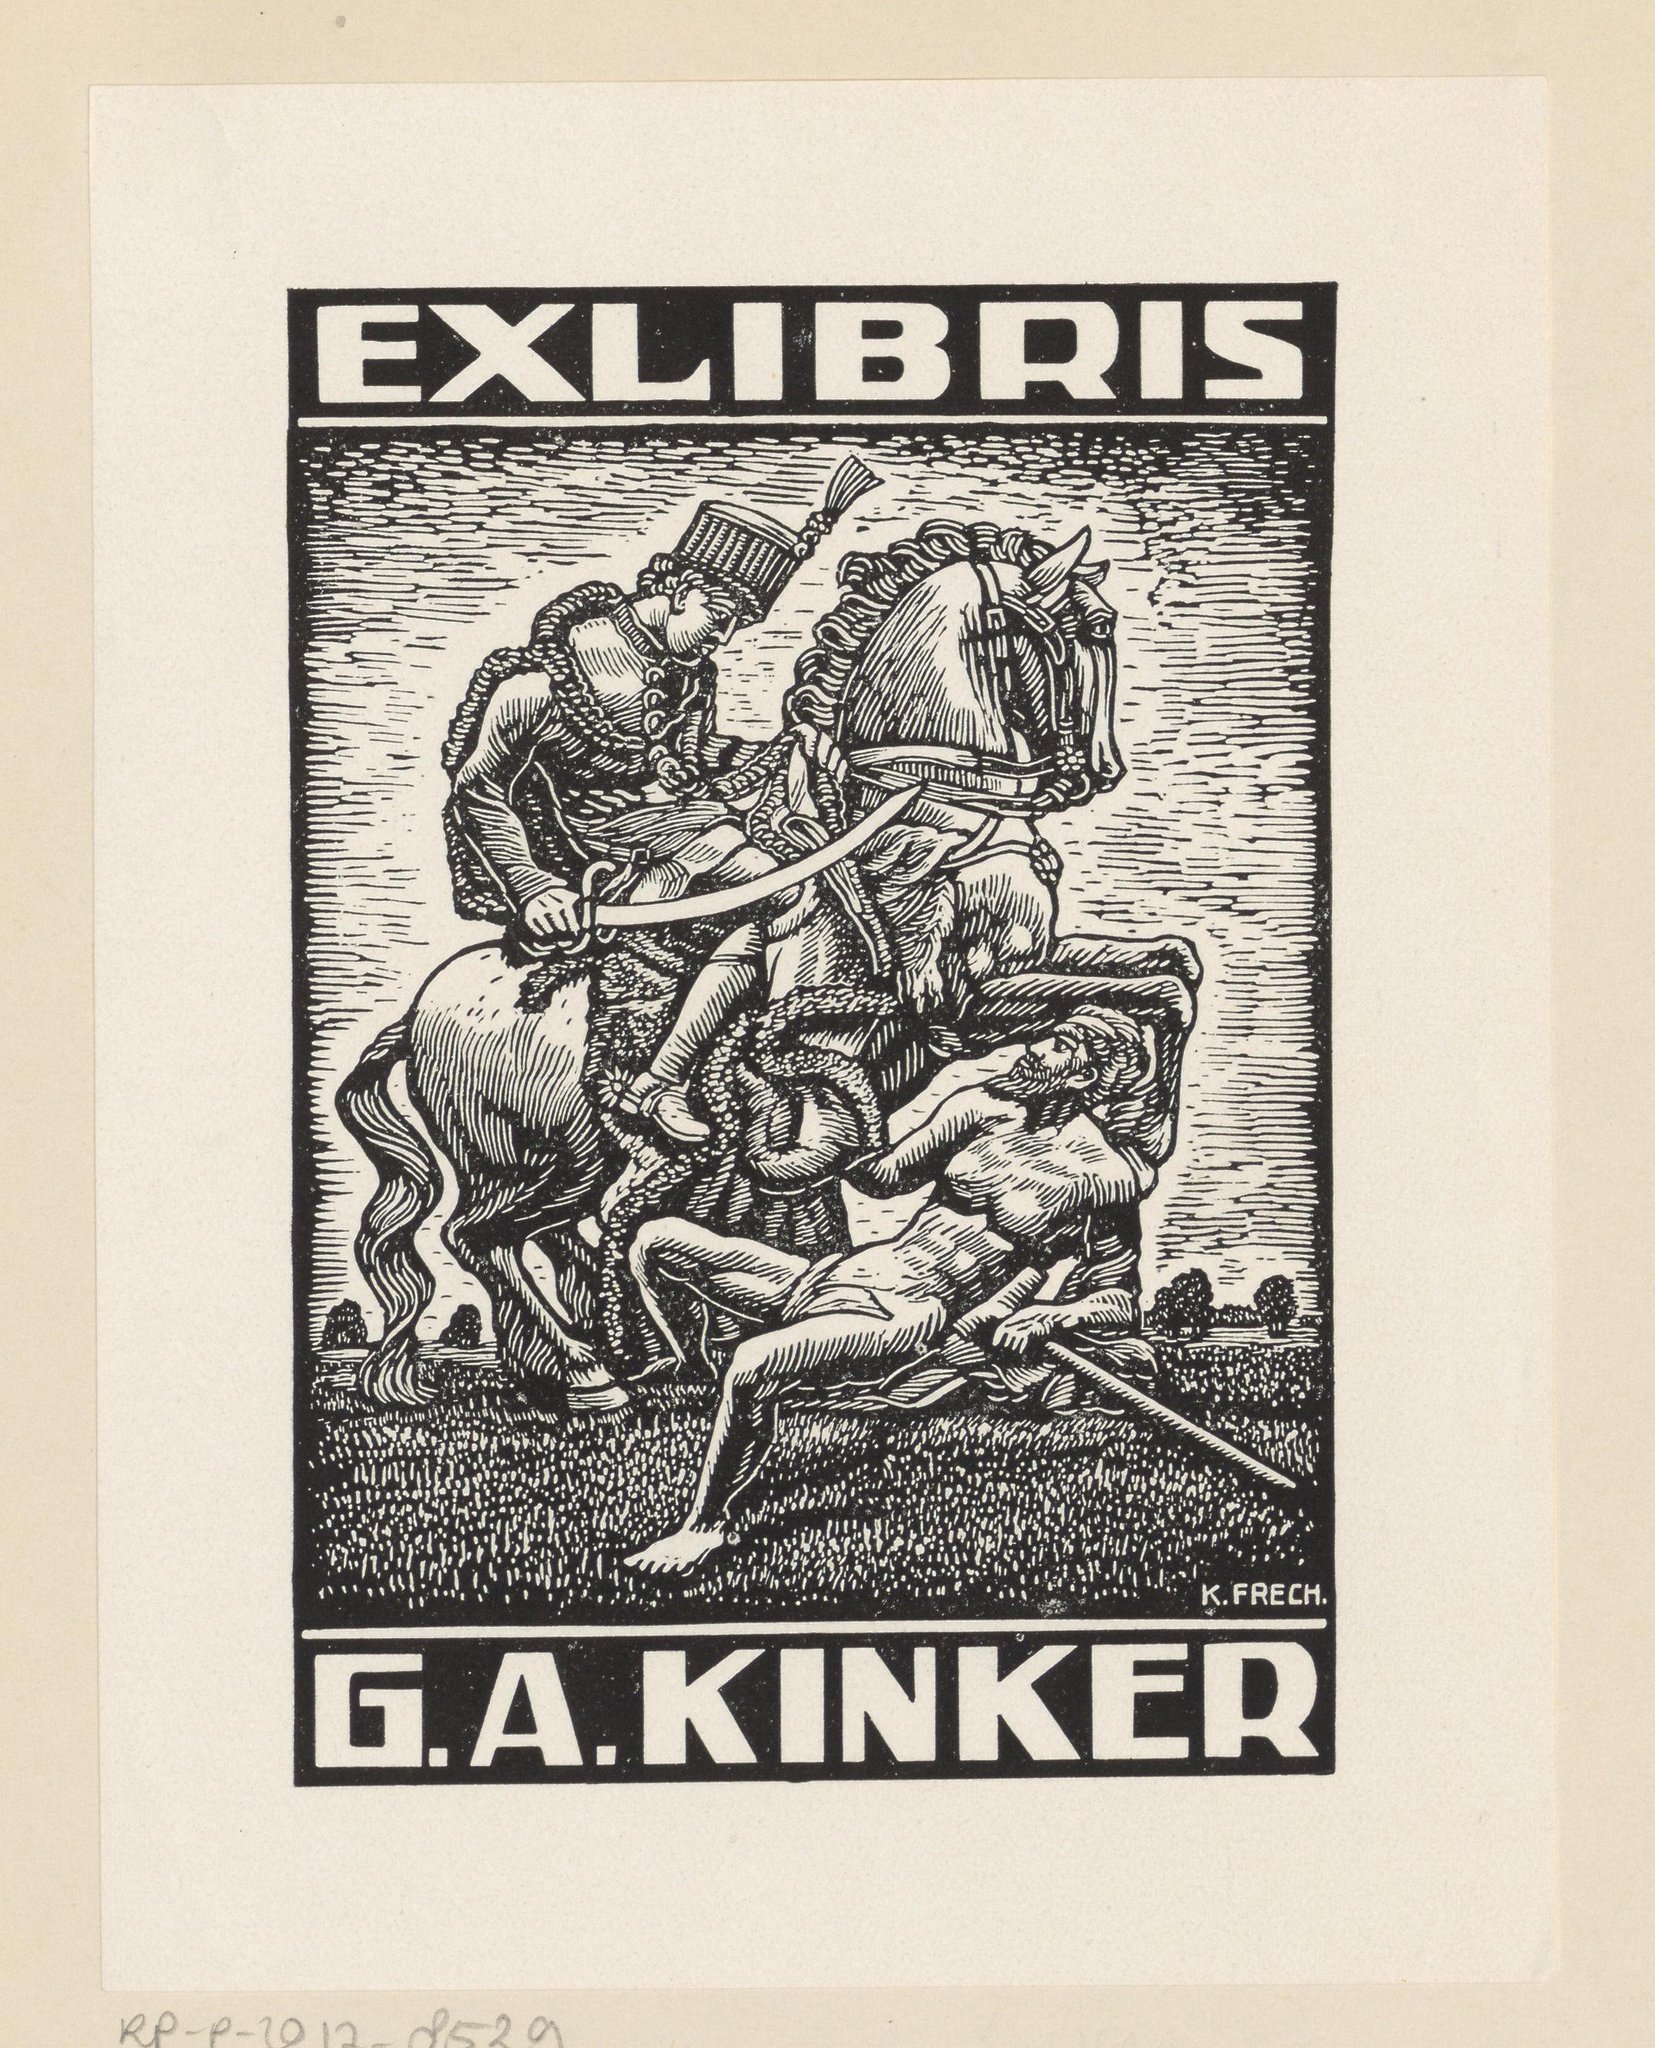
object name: bookplate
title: Ex libris van G.A. Kinker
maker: karl hugo frech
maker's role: print maker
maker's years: 1883-1945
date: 1939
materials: paper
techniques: linocut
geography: bratislava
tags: g.a. kinker, riding a horse, ass, or mule; rider, horseman, martin(us), bishop of tours; possible attributes: beggar, goose, man (showing himself) undressed, quasi-nude